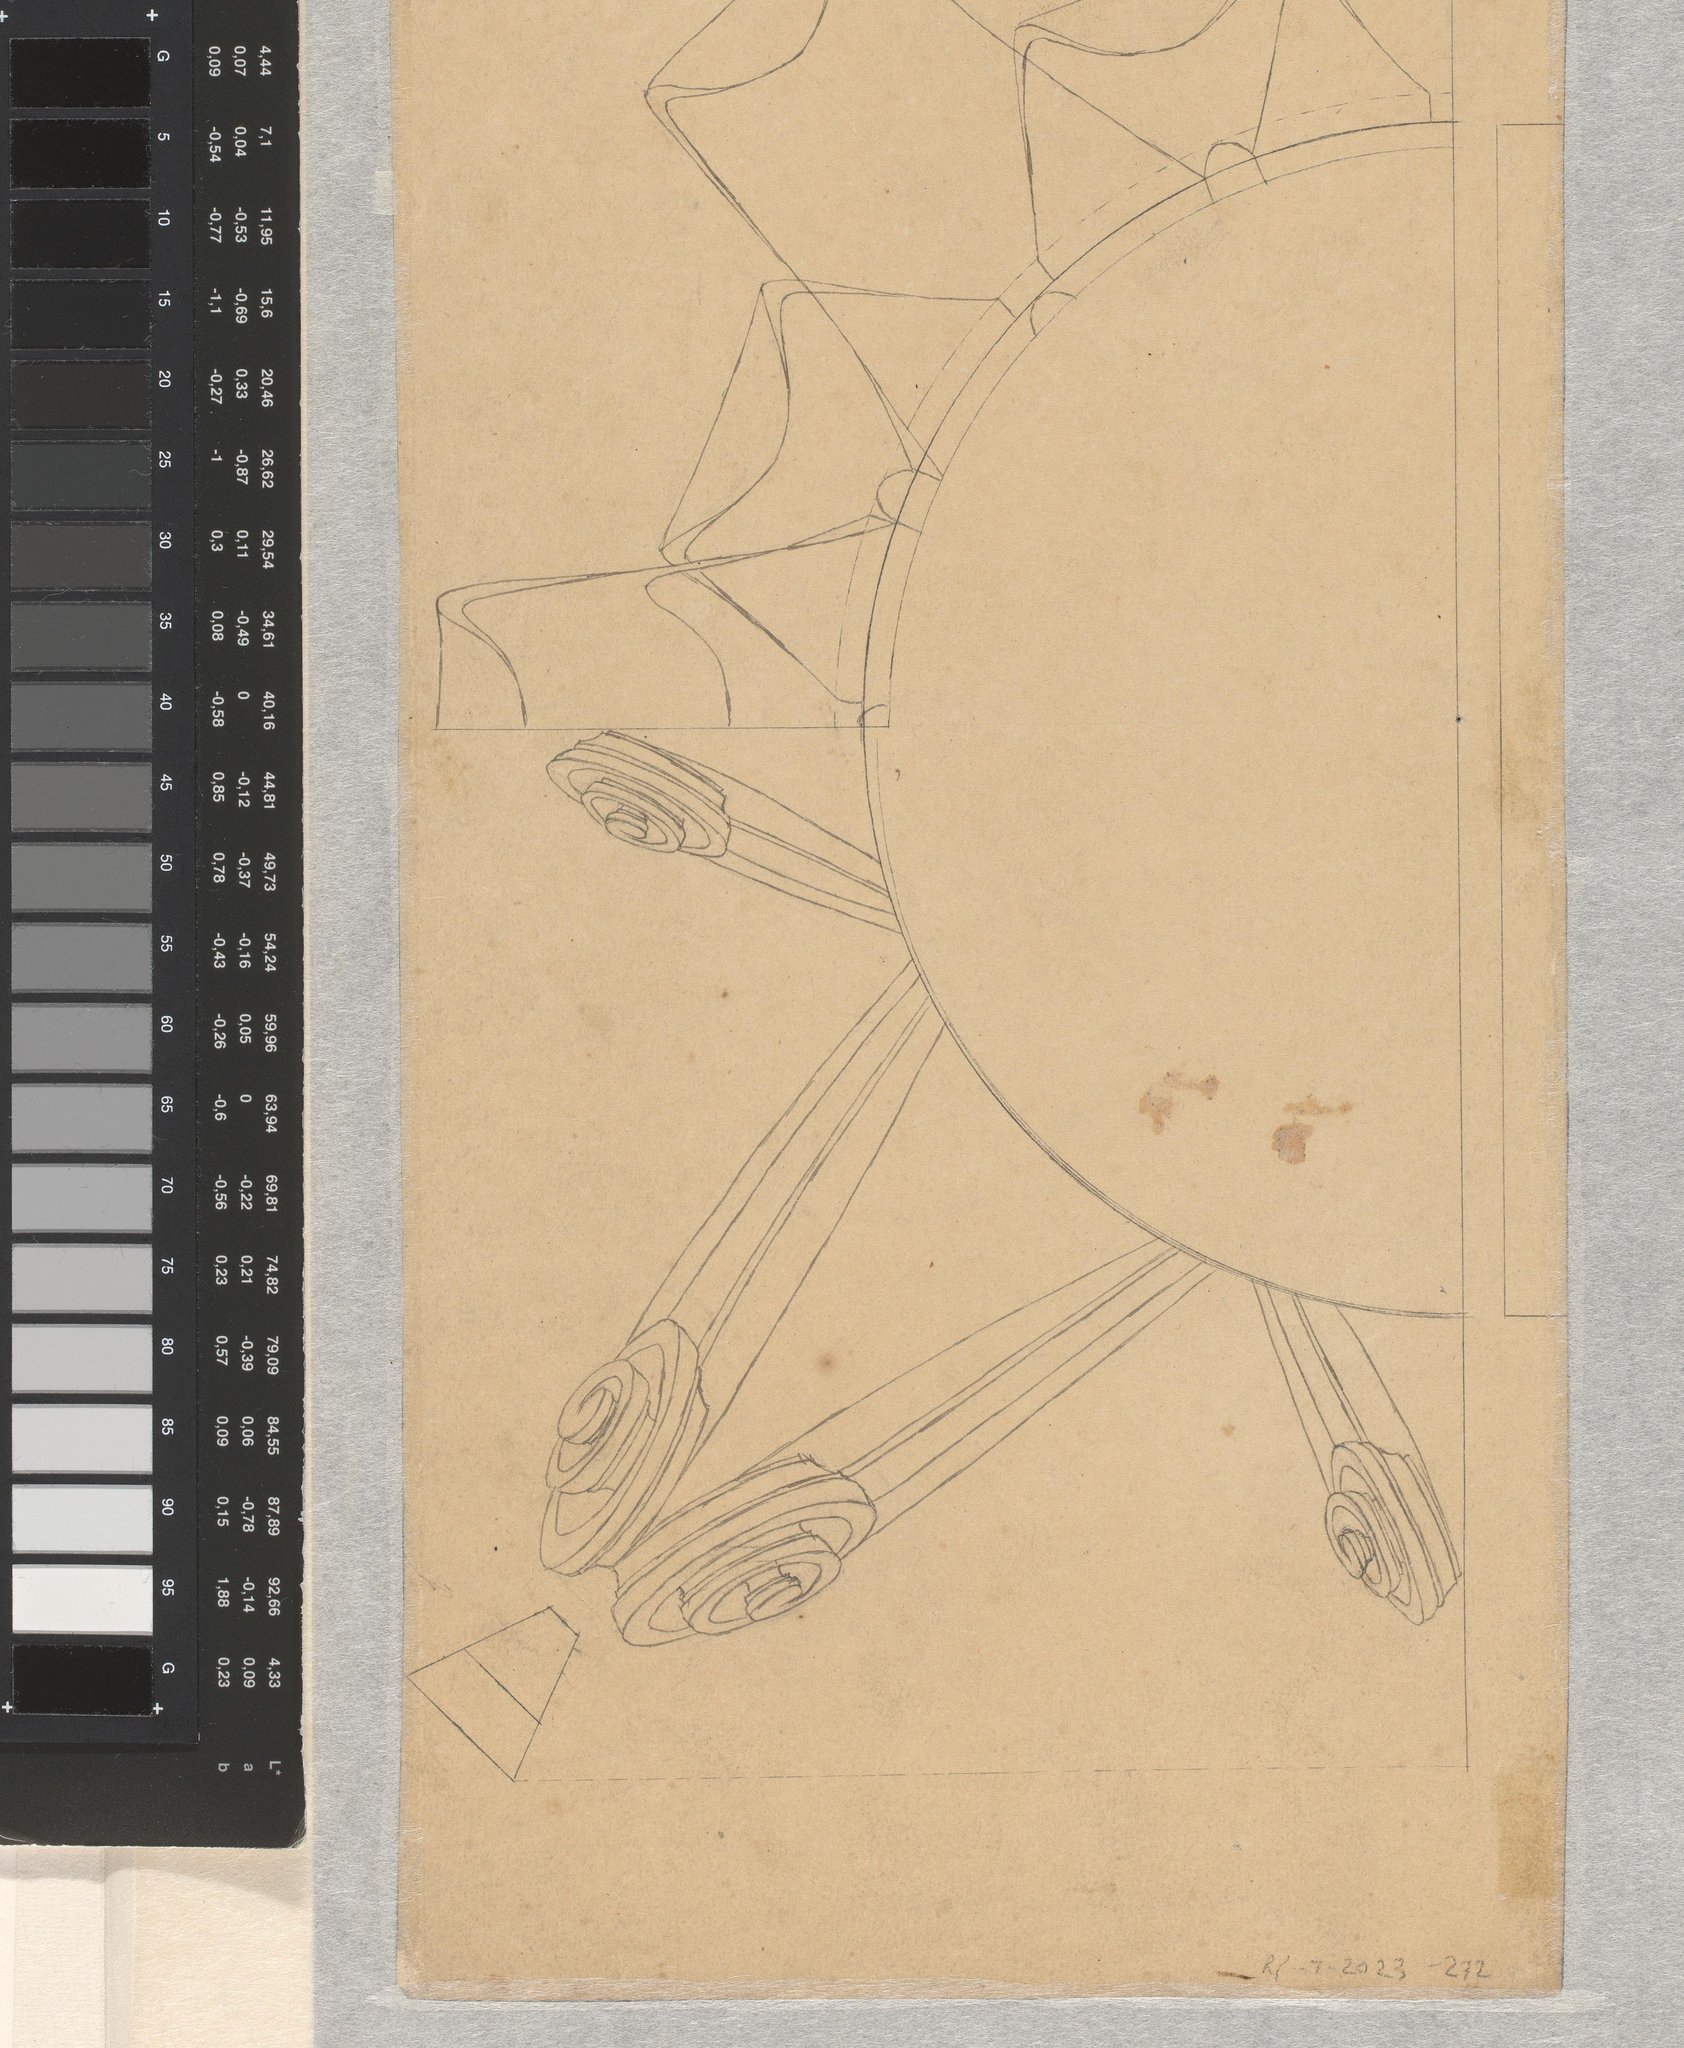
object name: design drawing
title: Twee kwartronde studies van bovenaanzichten van een schaal of ander object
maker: Anonymous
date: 1790-1810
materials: ink, paper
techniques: pen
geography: italy